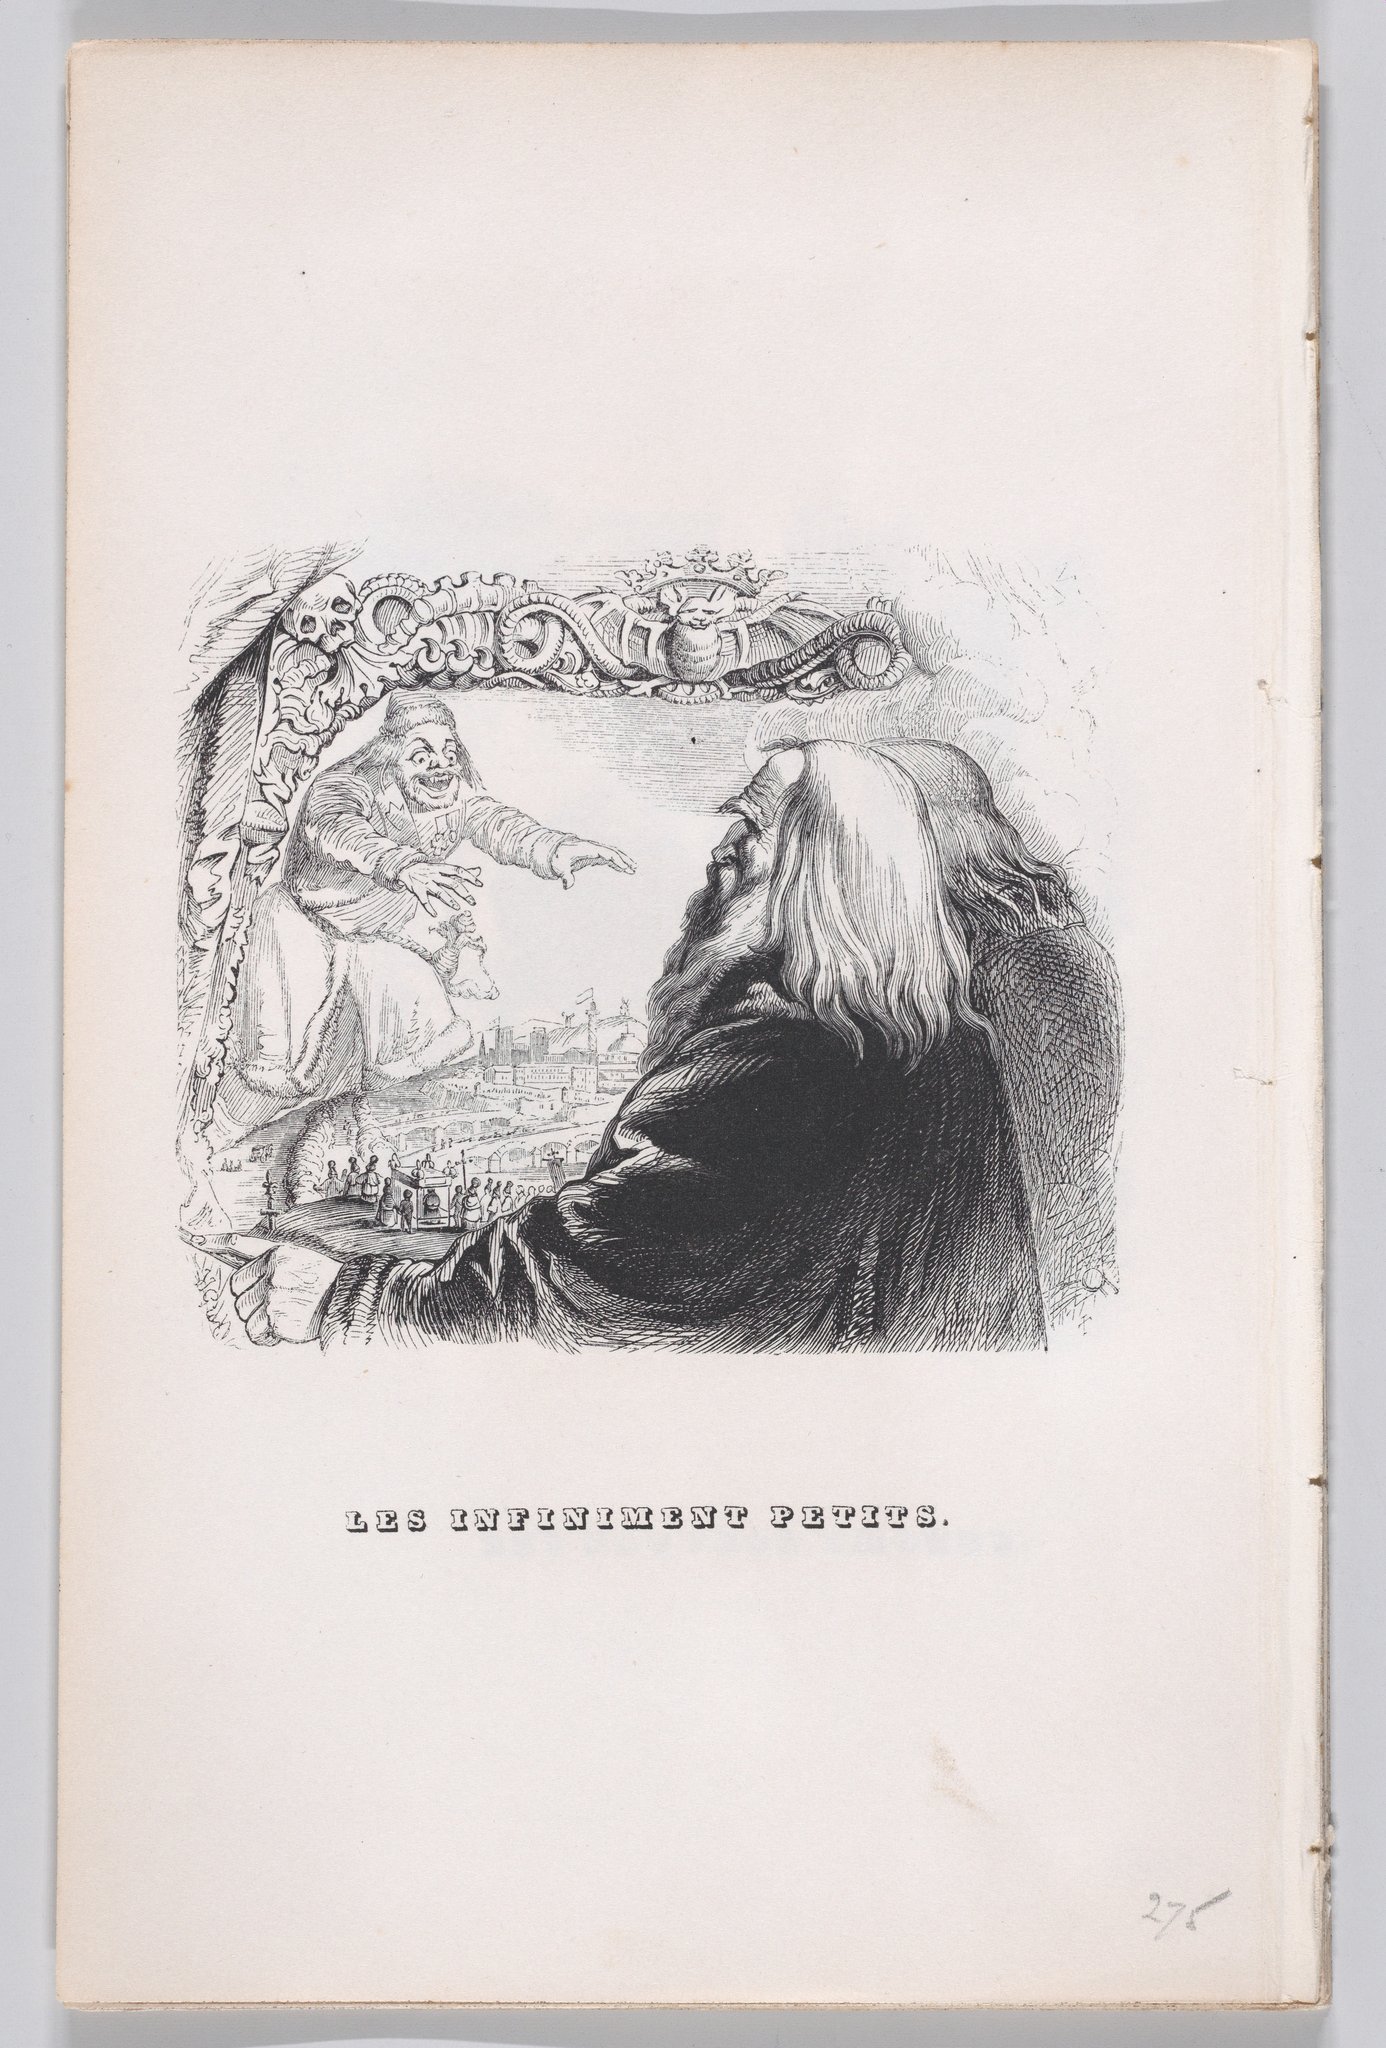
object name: print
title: Infinitely Small, from "The Complete Works of Béranger"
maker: j. j. grandville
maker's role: artist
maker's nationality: french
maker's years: 1803-1847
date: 1836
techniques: engraving